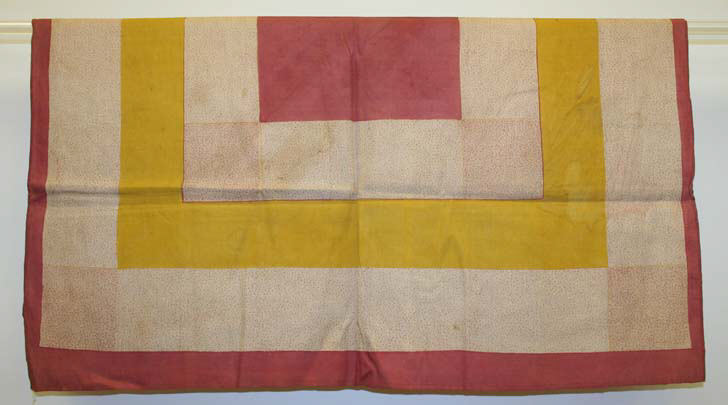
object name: kerchief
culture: spanish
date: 1701-1800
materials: silk